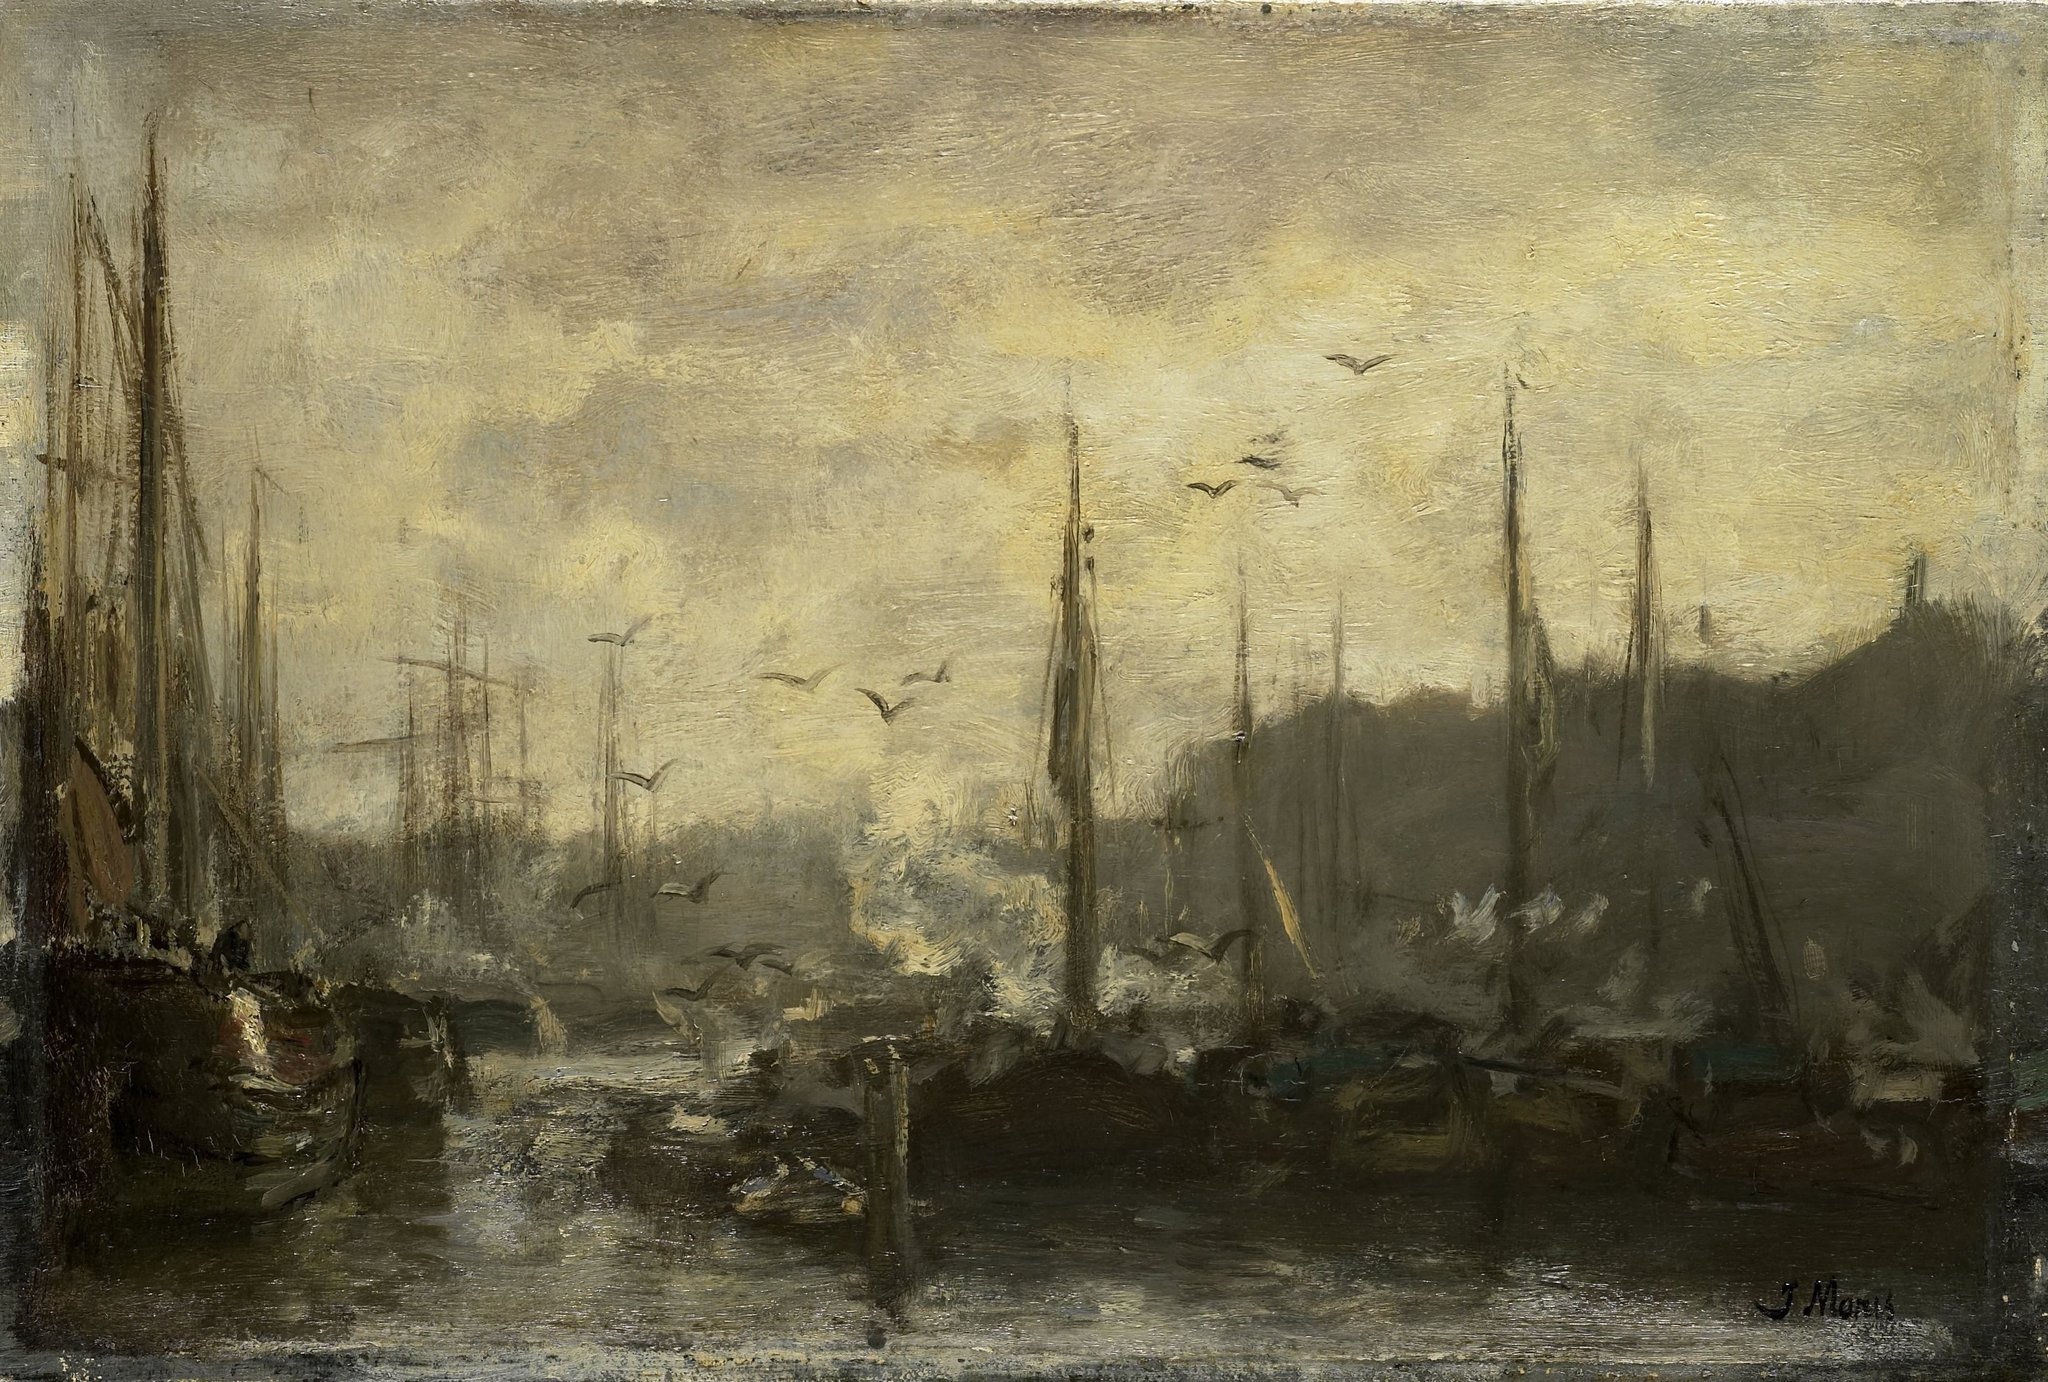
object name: painting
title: Harbor View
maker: jacob maris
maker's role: draughtsman, painter, print maker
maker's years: 1837-1899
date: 1887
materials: canvas, oil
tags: sailing-ship, sailing-boat, quay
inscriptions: signature: ‘J. Maris’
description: Gezicht op een haven vol met schuiten. Uit een schip links stijgt rook omhoog, boven het water vliegen meeuwen.